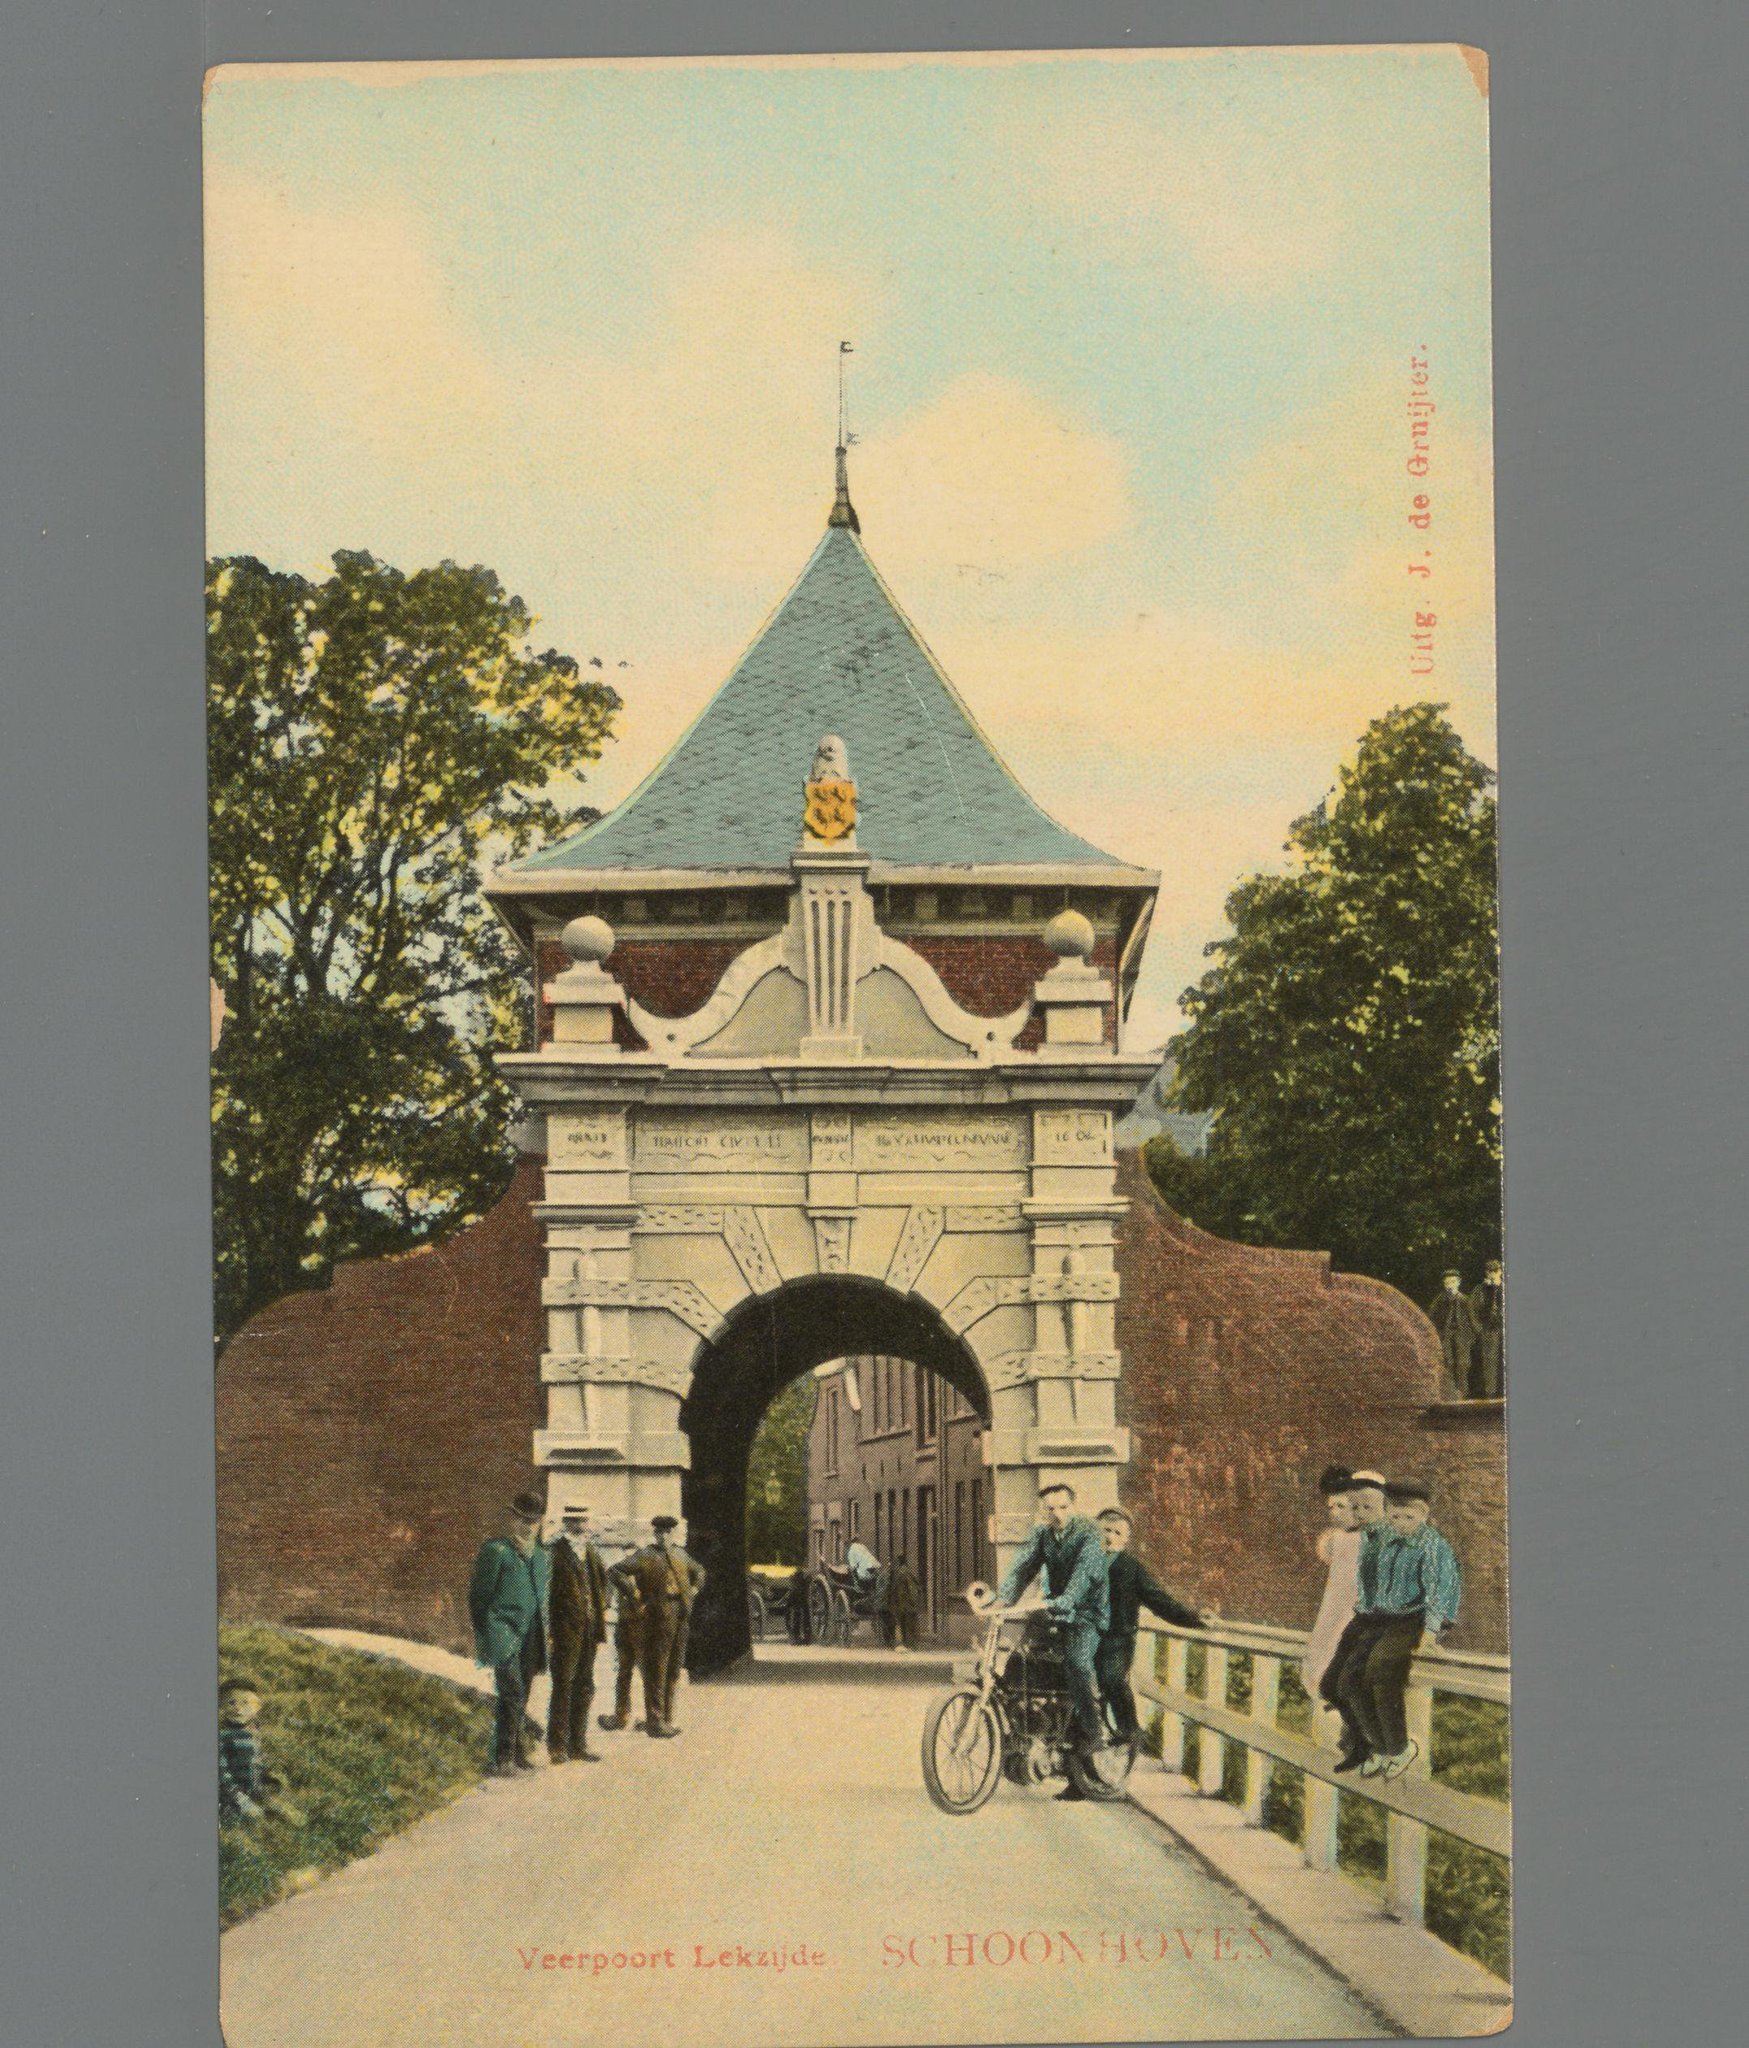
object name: photomechanical print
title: Veerpoort Lekzijde. Schoonhoven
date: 1905-1919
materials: cardboard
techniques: lithograph, writing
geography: schoonhoven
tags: city-gate